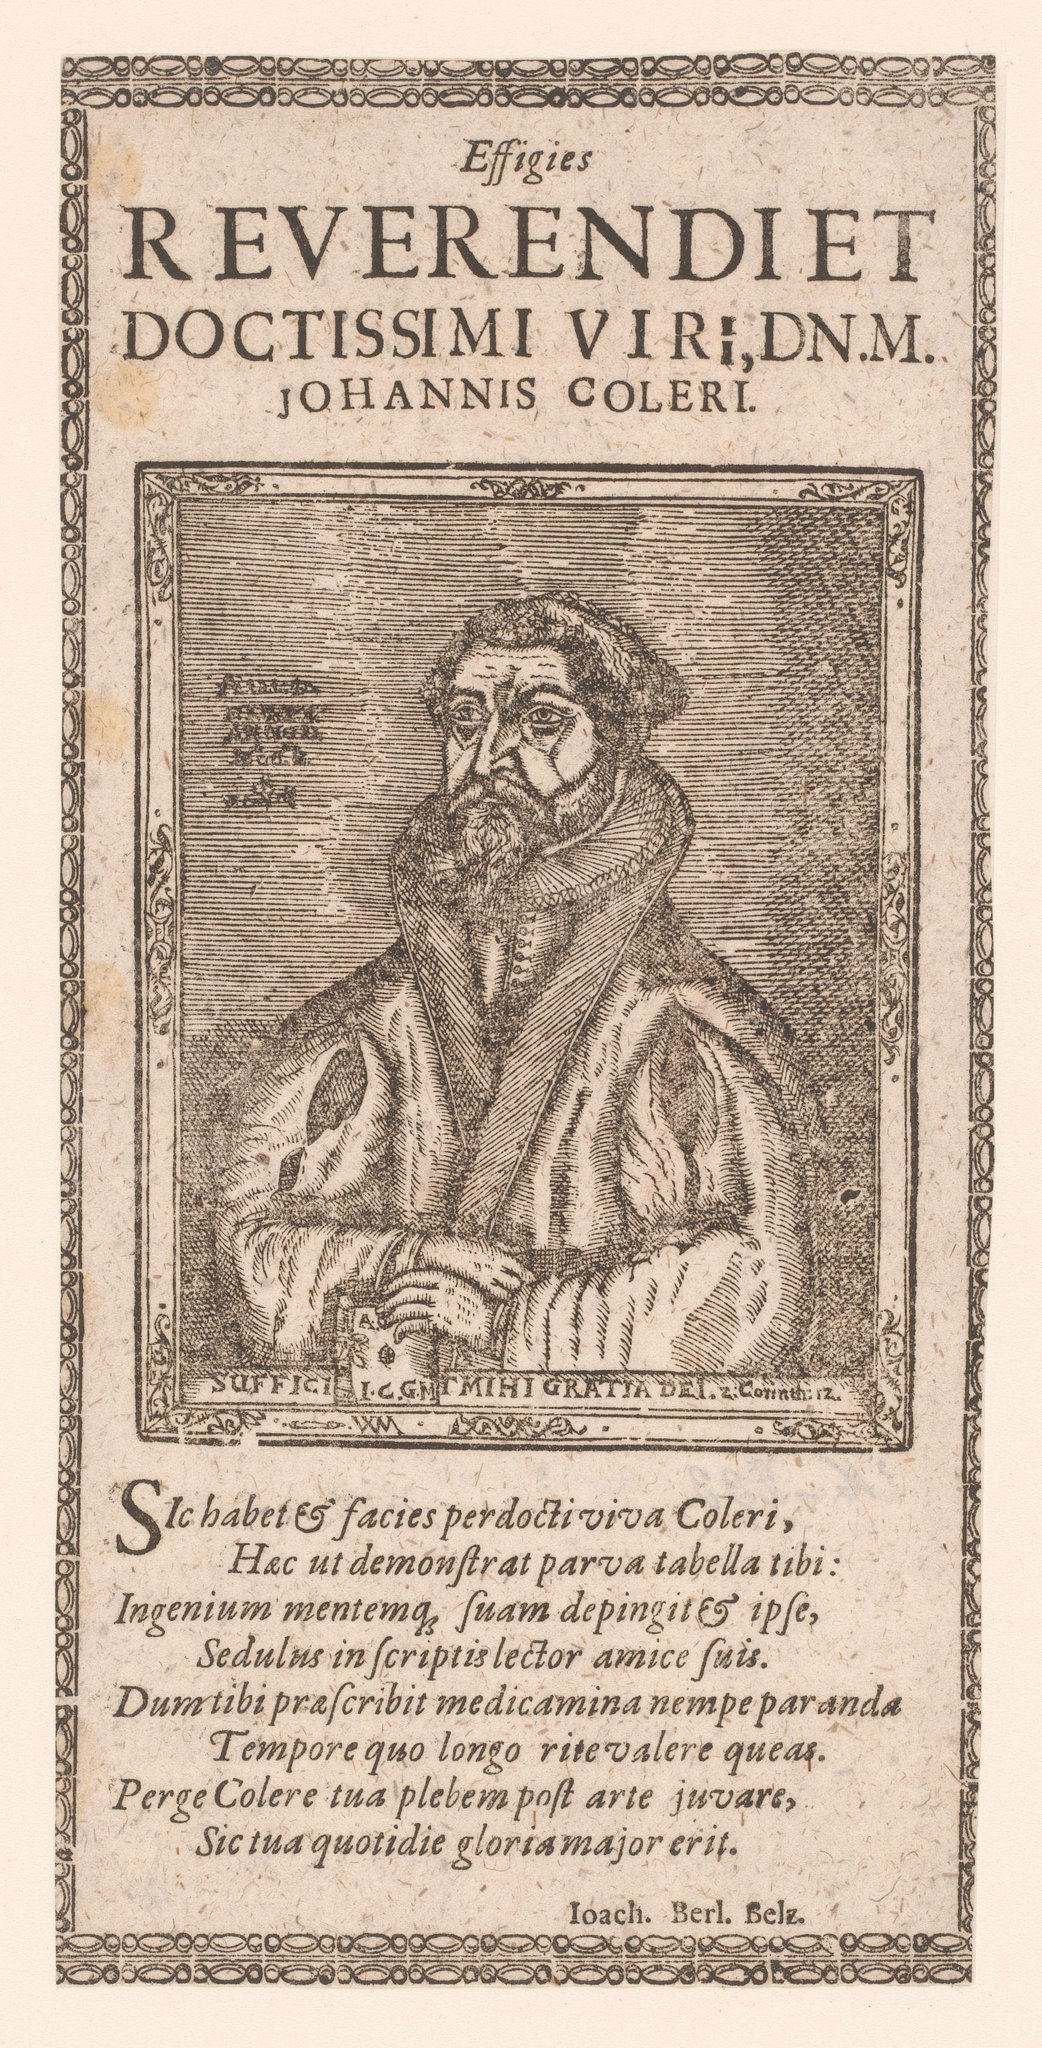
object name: print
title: Portret van Johann Coler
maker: monogrammist wm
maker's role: print maker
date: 1550-1649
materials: paper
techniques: woodcut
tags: johann coler, historical persons